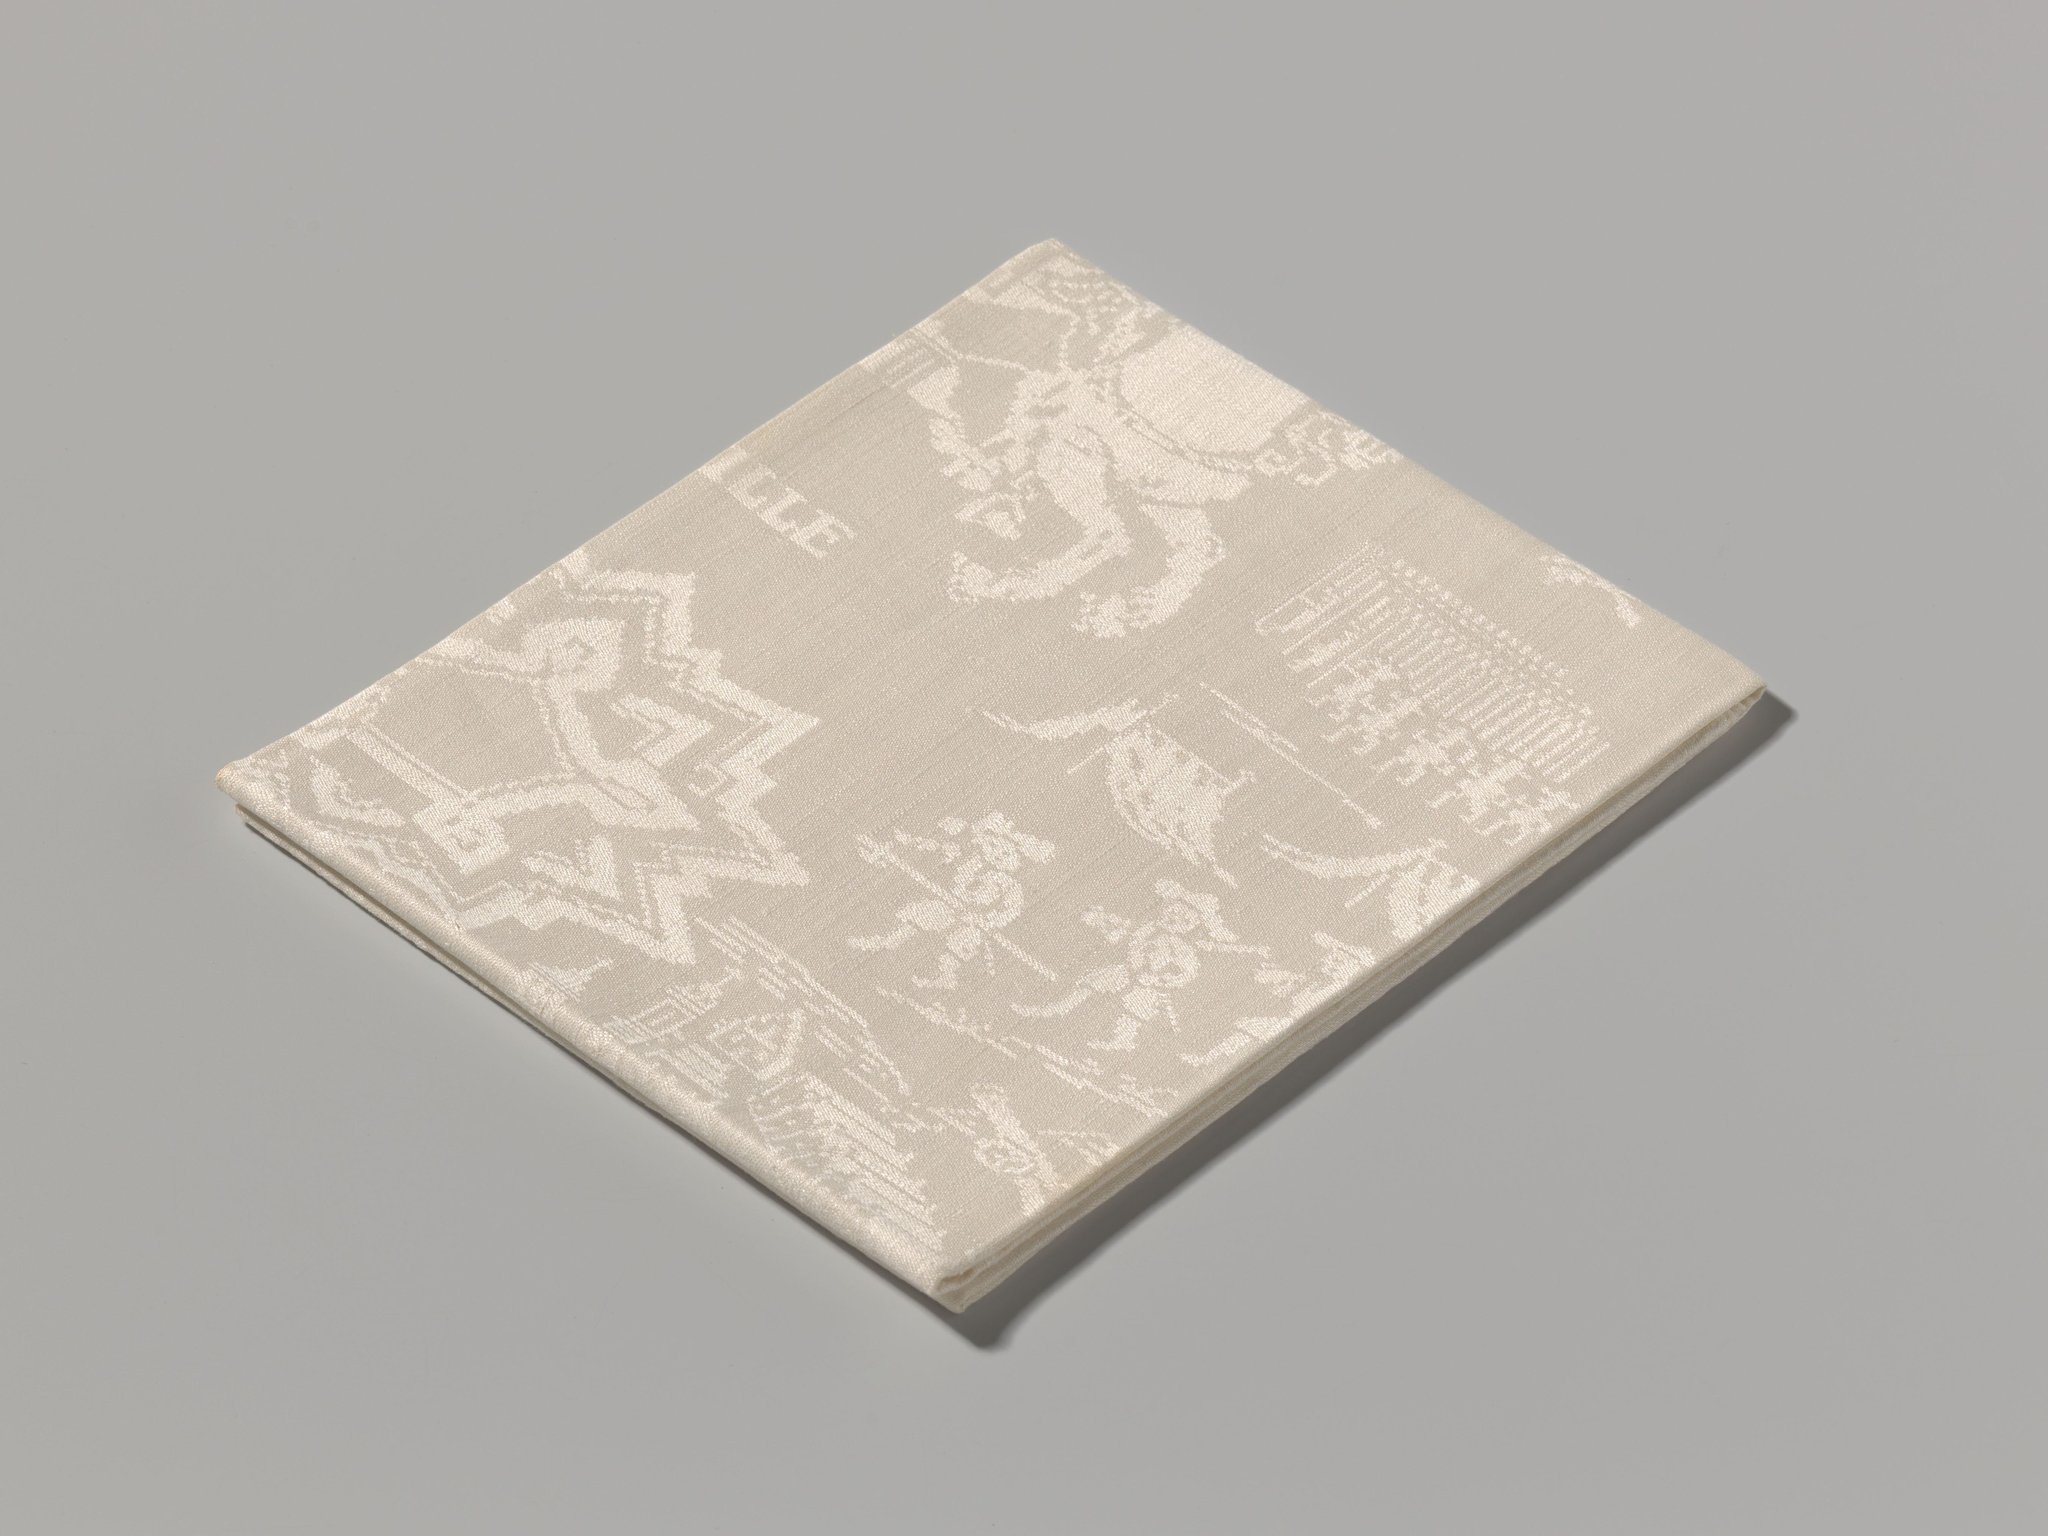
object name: napkin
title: Servet met het wapen van Karel III van Spanje en een gezicht op Rijssel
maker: Anonymous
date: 1702-1713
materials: linen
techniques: damask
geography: kortrijk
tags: vienna, charles vi (holy roman emperor), lille, spain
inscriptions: mark: ‘13’, mark: ‘? S’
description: Servet van linnendamast met het wapen van Karel III van Spanje en een gezicht op Rijssel. Het symmetrisch patroon vertoont van onder naar boven de volgende taferelen: 1 Een gezicht op Rijssel met vele torens. 2 Plattegrond van een vesting met bovenschrift LILLE. 3 Ruiter te paard (Karel III van Spanje?). 4 Het wapen van Karel III van Spanje geflankeerd door vaandels. Staande en liggende randen: wapens, onder andere Savoye, en wapentrofeeën; daarbuiten: blokkenrand.